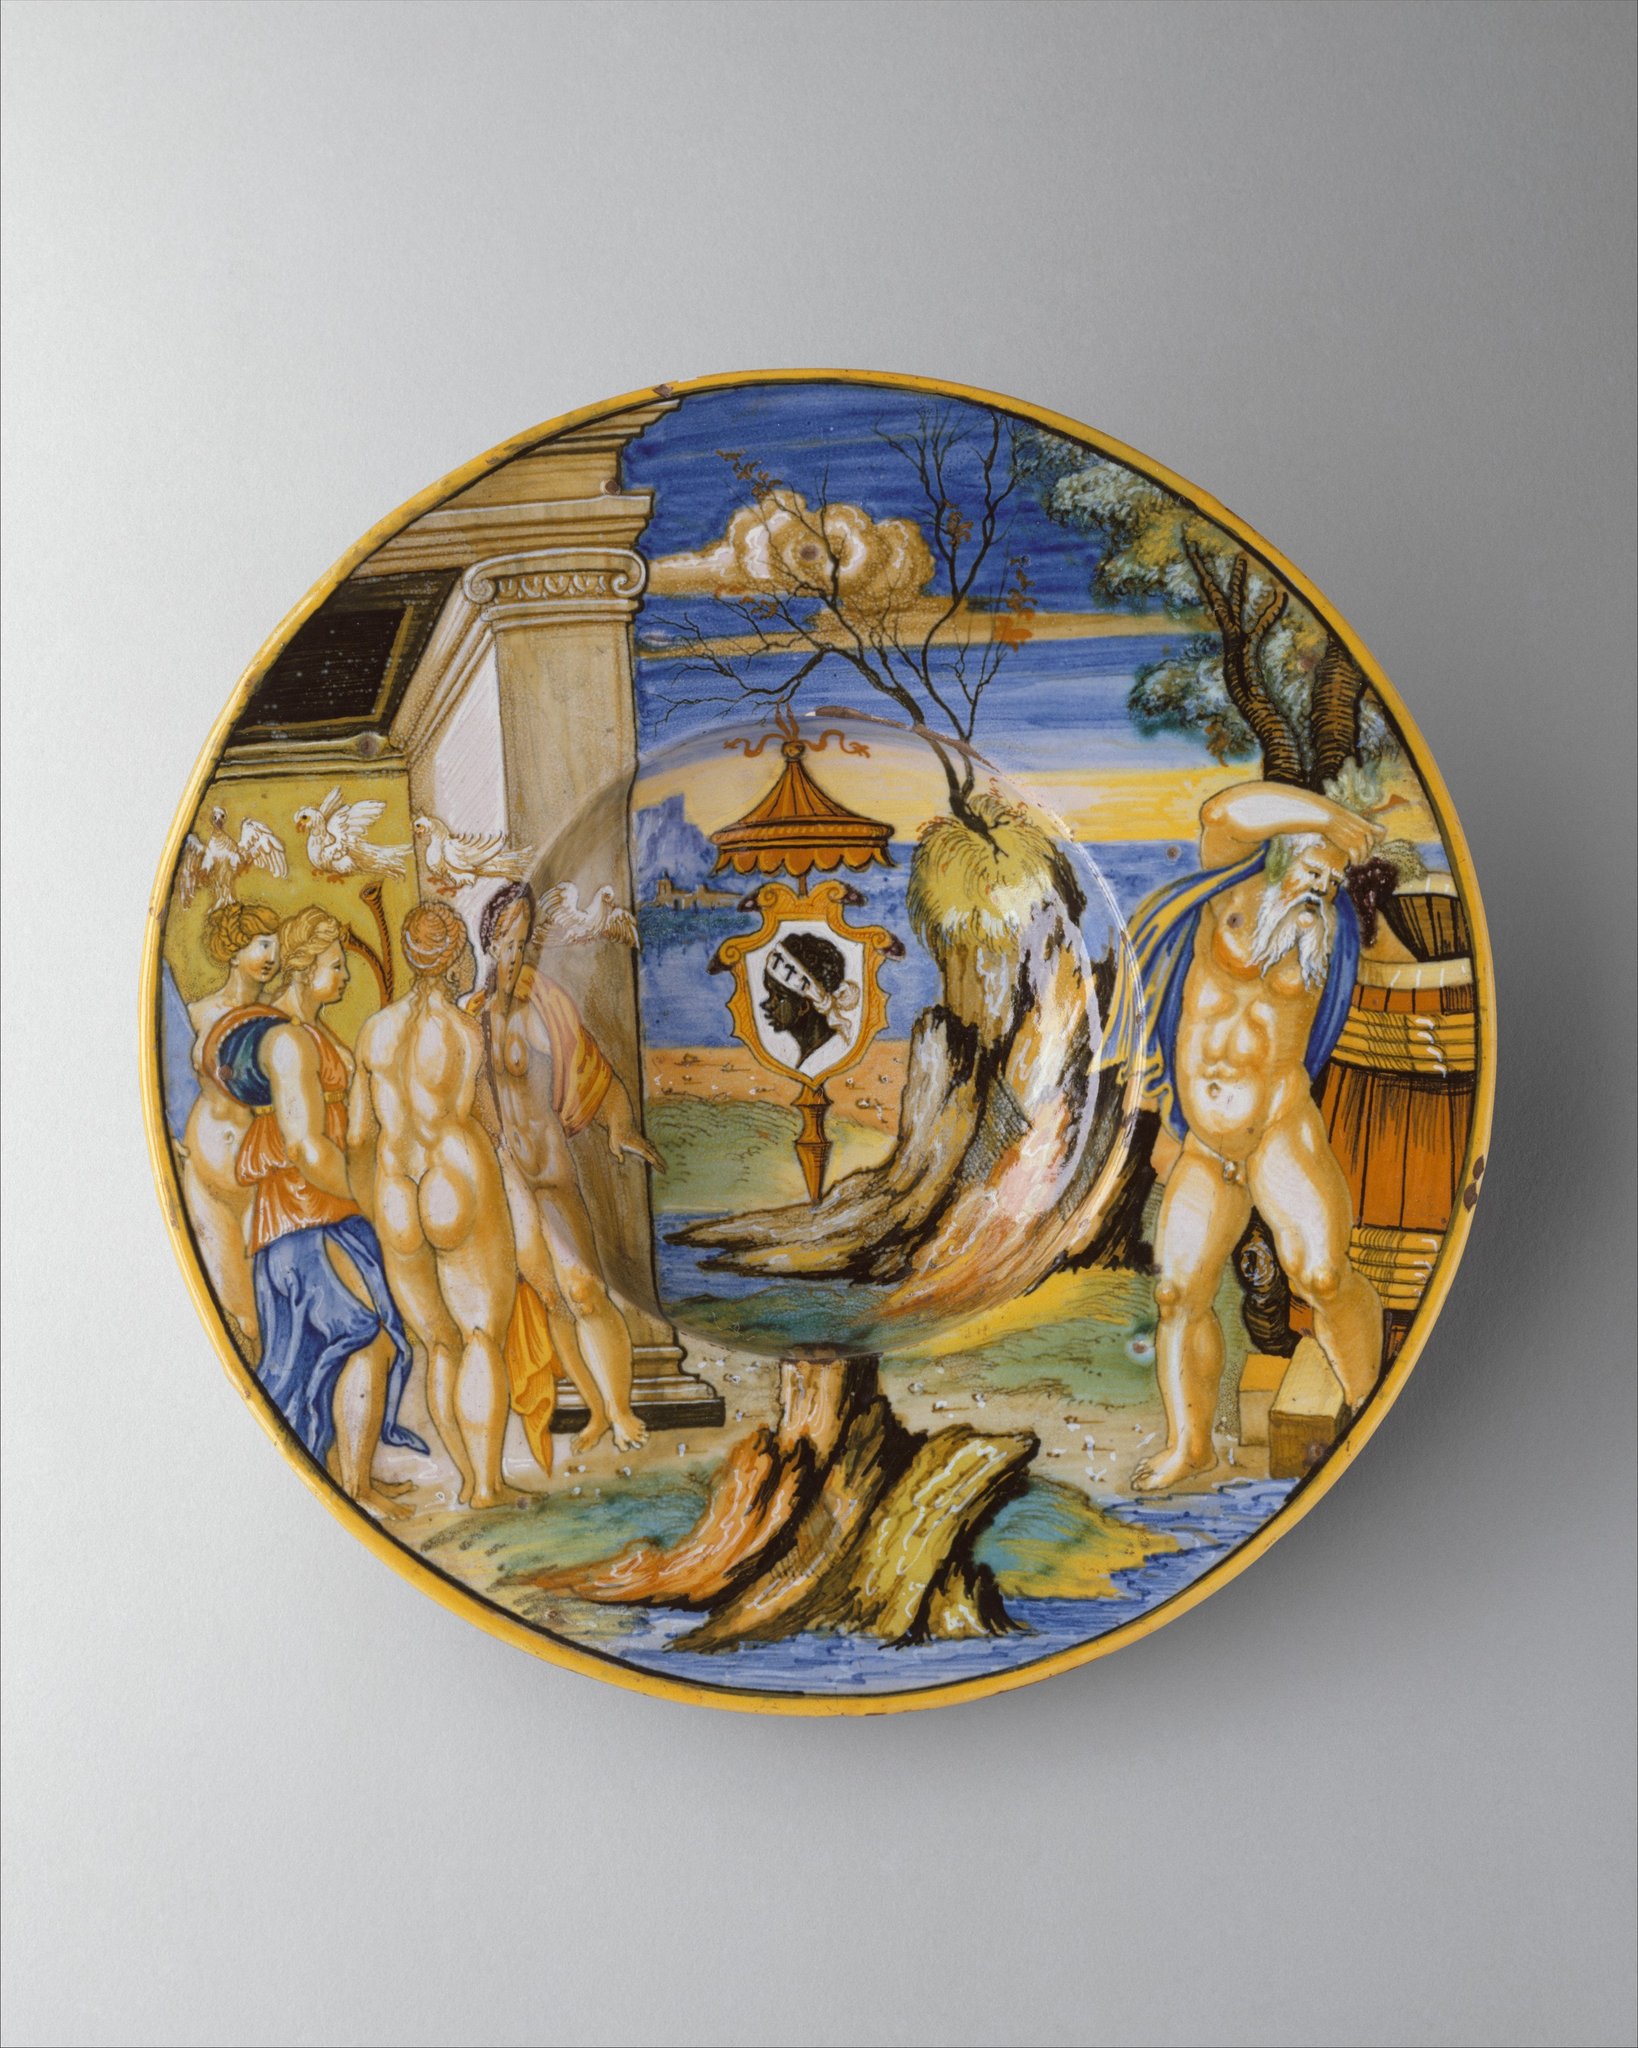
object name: dish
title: Armorial dish: The story of King Anius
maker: francesco xanto avelli da rovigo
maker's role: artist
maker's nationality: italian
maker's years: 1482-1542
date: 1532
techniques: maiolica, glazing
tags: doves,male nudes,female nudes,coat of arms